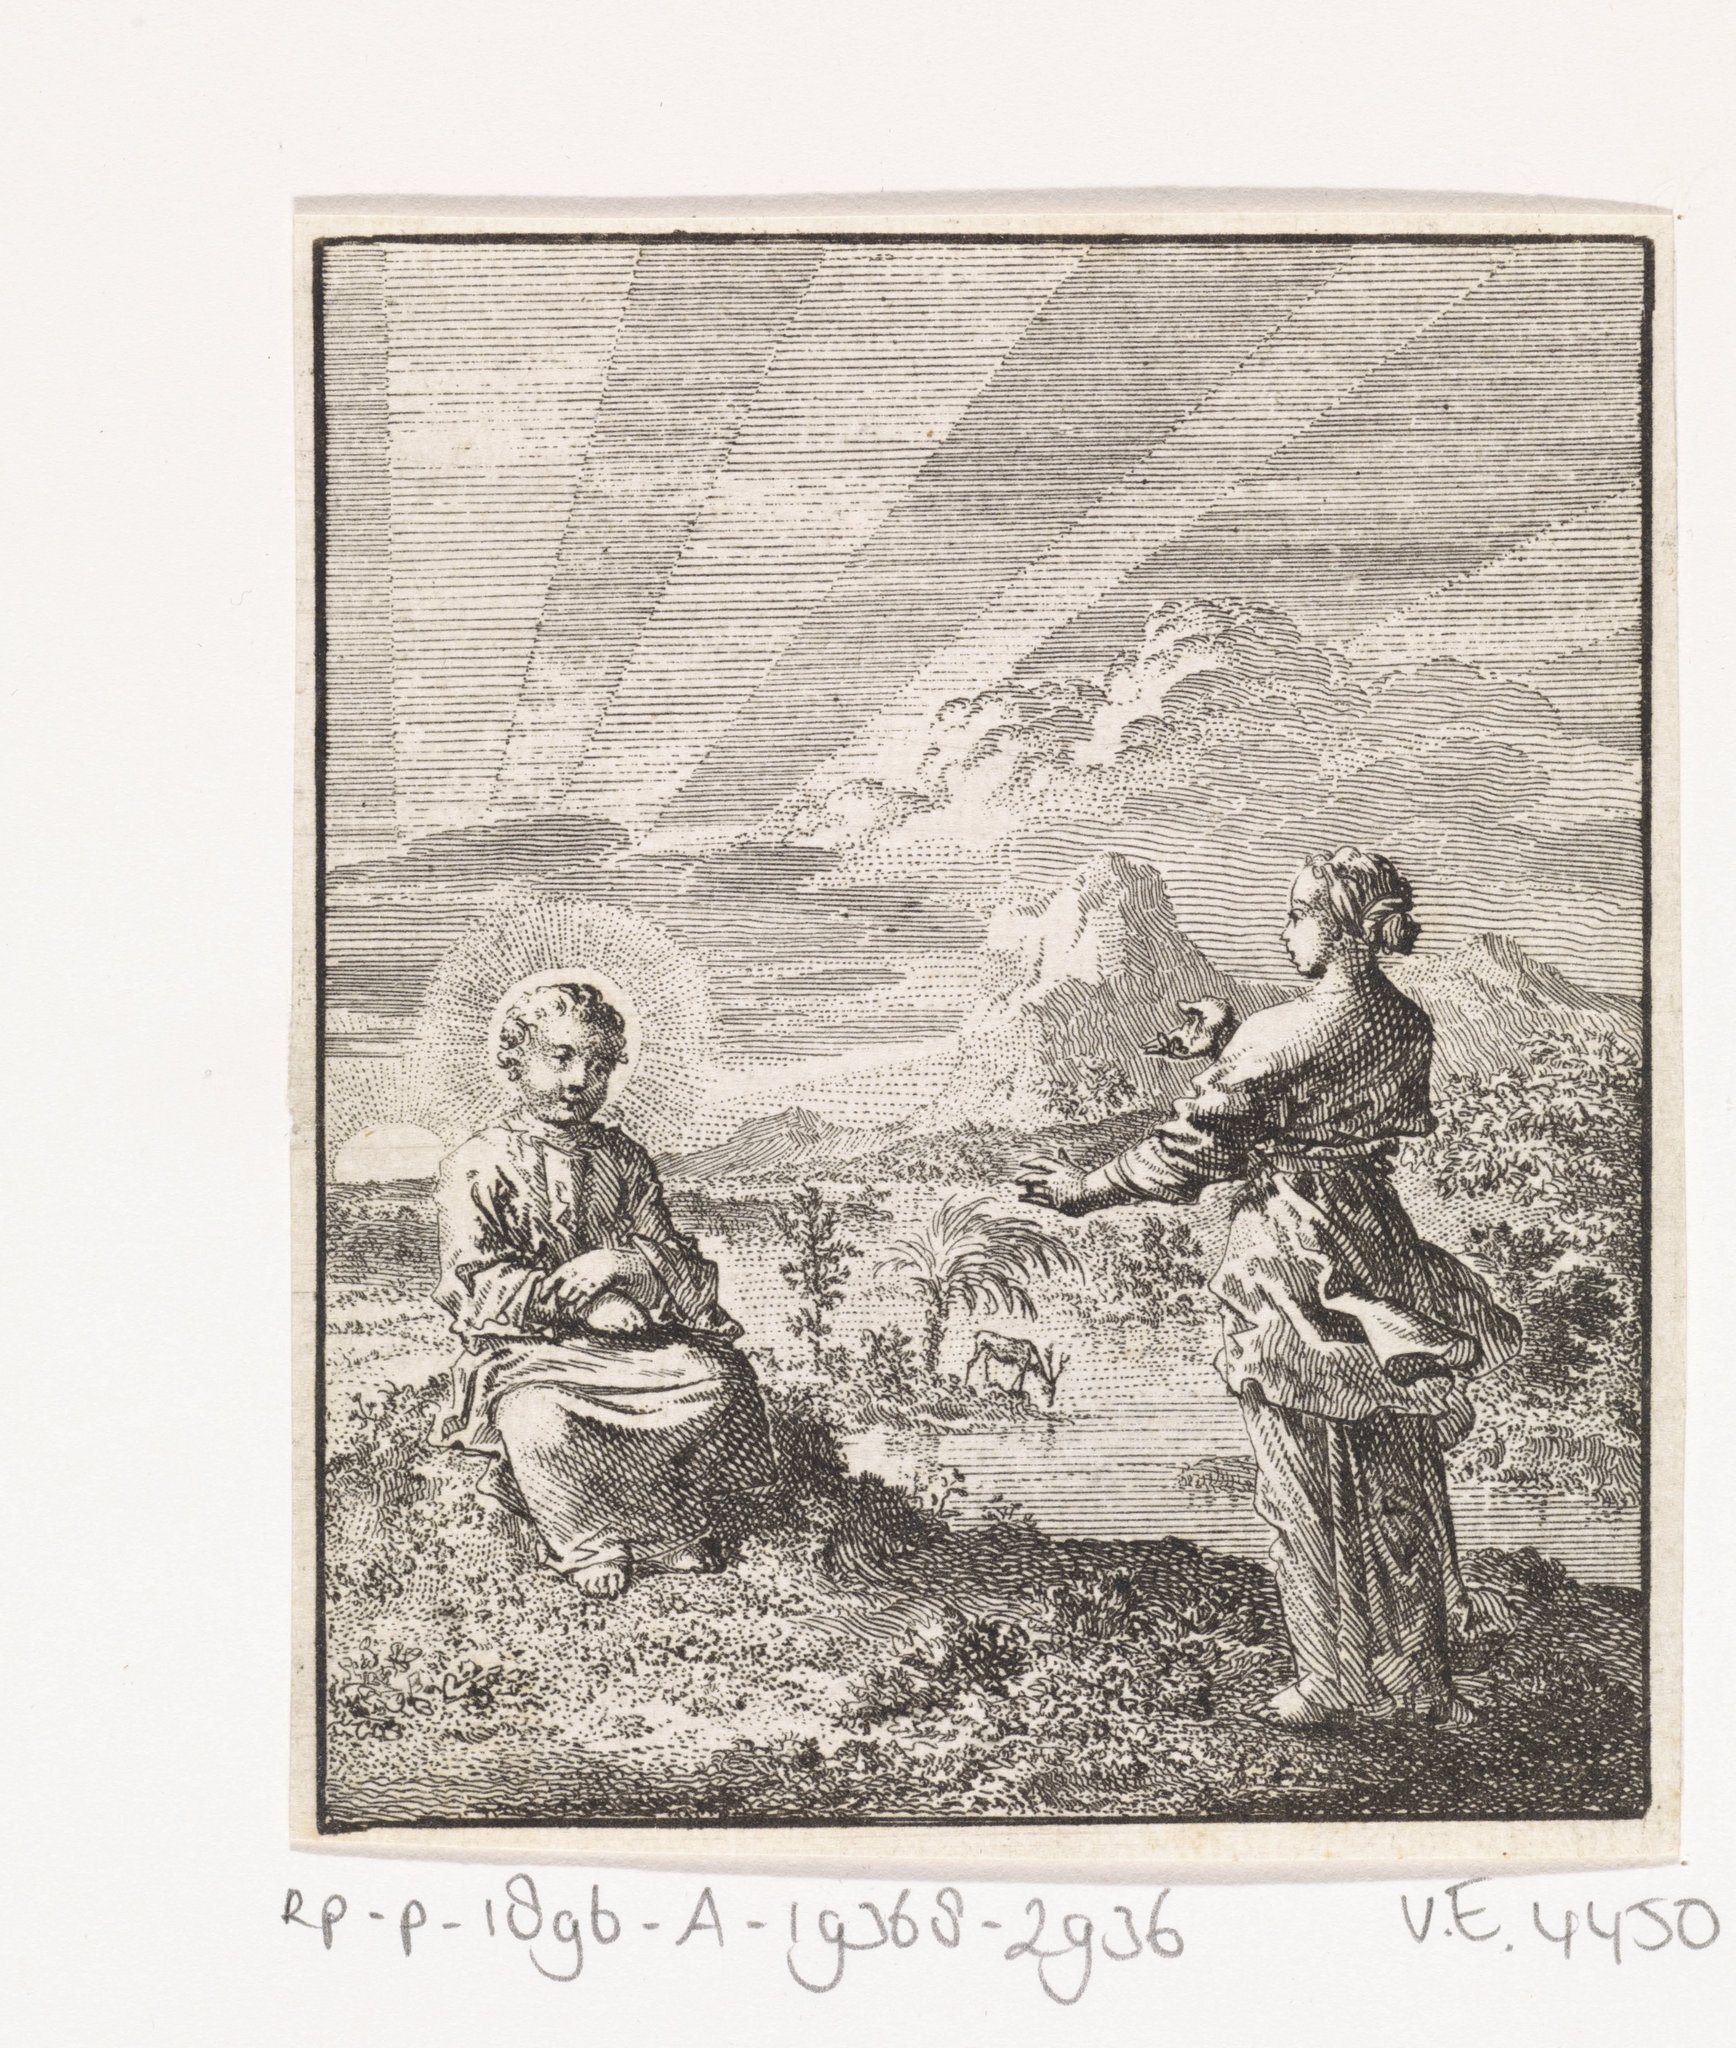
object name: print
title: Christus en de gepersonifieerde ziel aanschouwen de opkomende zon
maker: jan luyken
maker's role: draughtsman, print maker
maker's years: 1649-1712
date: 1714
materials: paper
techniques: etching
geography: amsterdam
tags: sunrise, christ and the soul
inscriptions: collector's mark: Lugt 2228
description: Proefdruk van illustratie uit: Luyken, Jan. Jezus en de Ziel, 3 delen. Amsterdam: Wed. Pieter Arentsz II en Cornelis van der Sys, 1714, dl. I, p. 47.